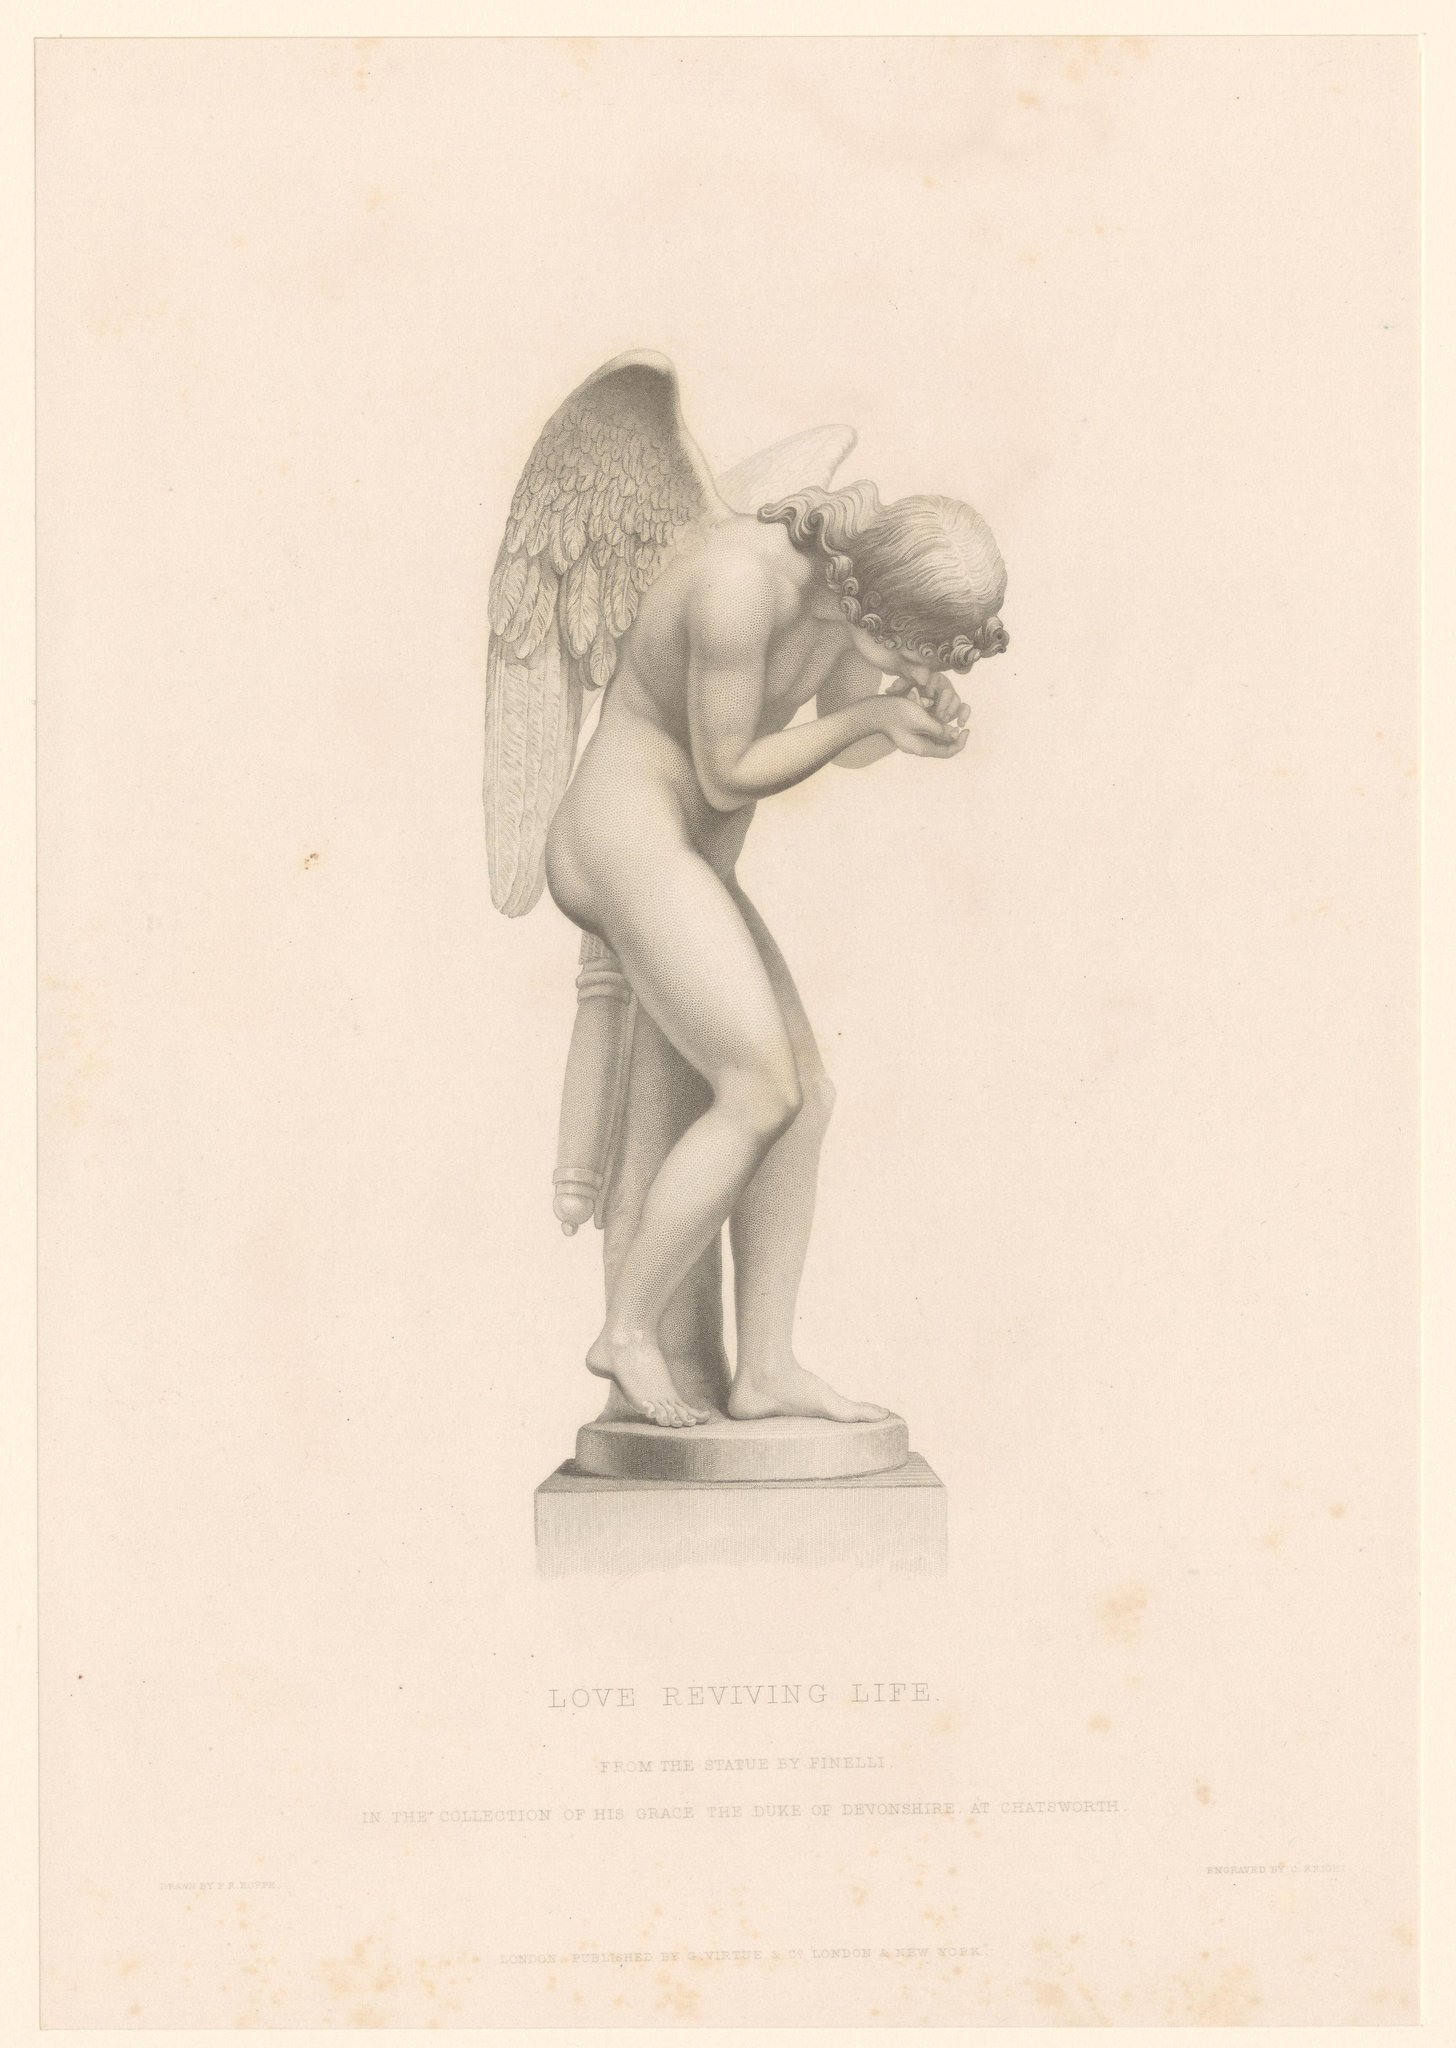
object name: print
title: Cupido met een vlinder in zijn handen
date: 1855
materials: paper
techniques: stippling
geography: london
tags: triumph of cupid, love personified, life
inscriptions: collector's mark: Lugt 2228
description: Tekst in het Engels in de ondermarge. De personificatie van de liefde houdt een vlinder, als symbool van het leven, voorzichtig in de handen.